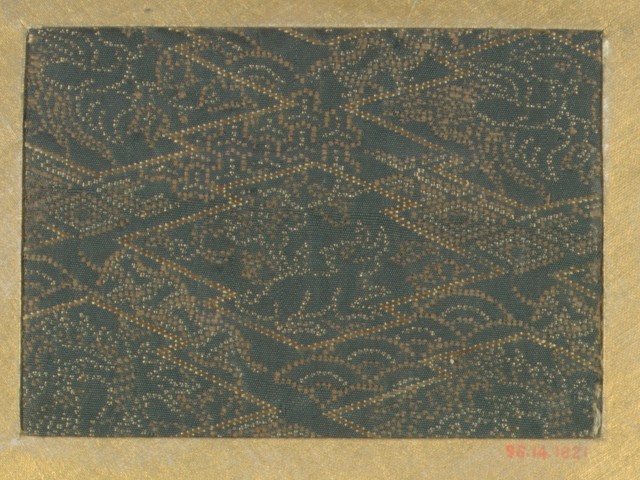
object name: piece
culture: japanese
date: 1701-1900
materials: silk